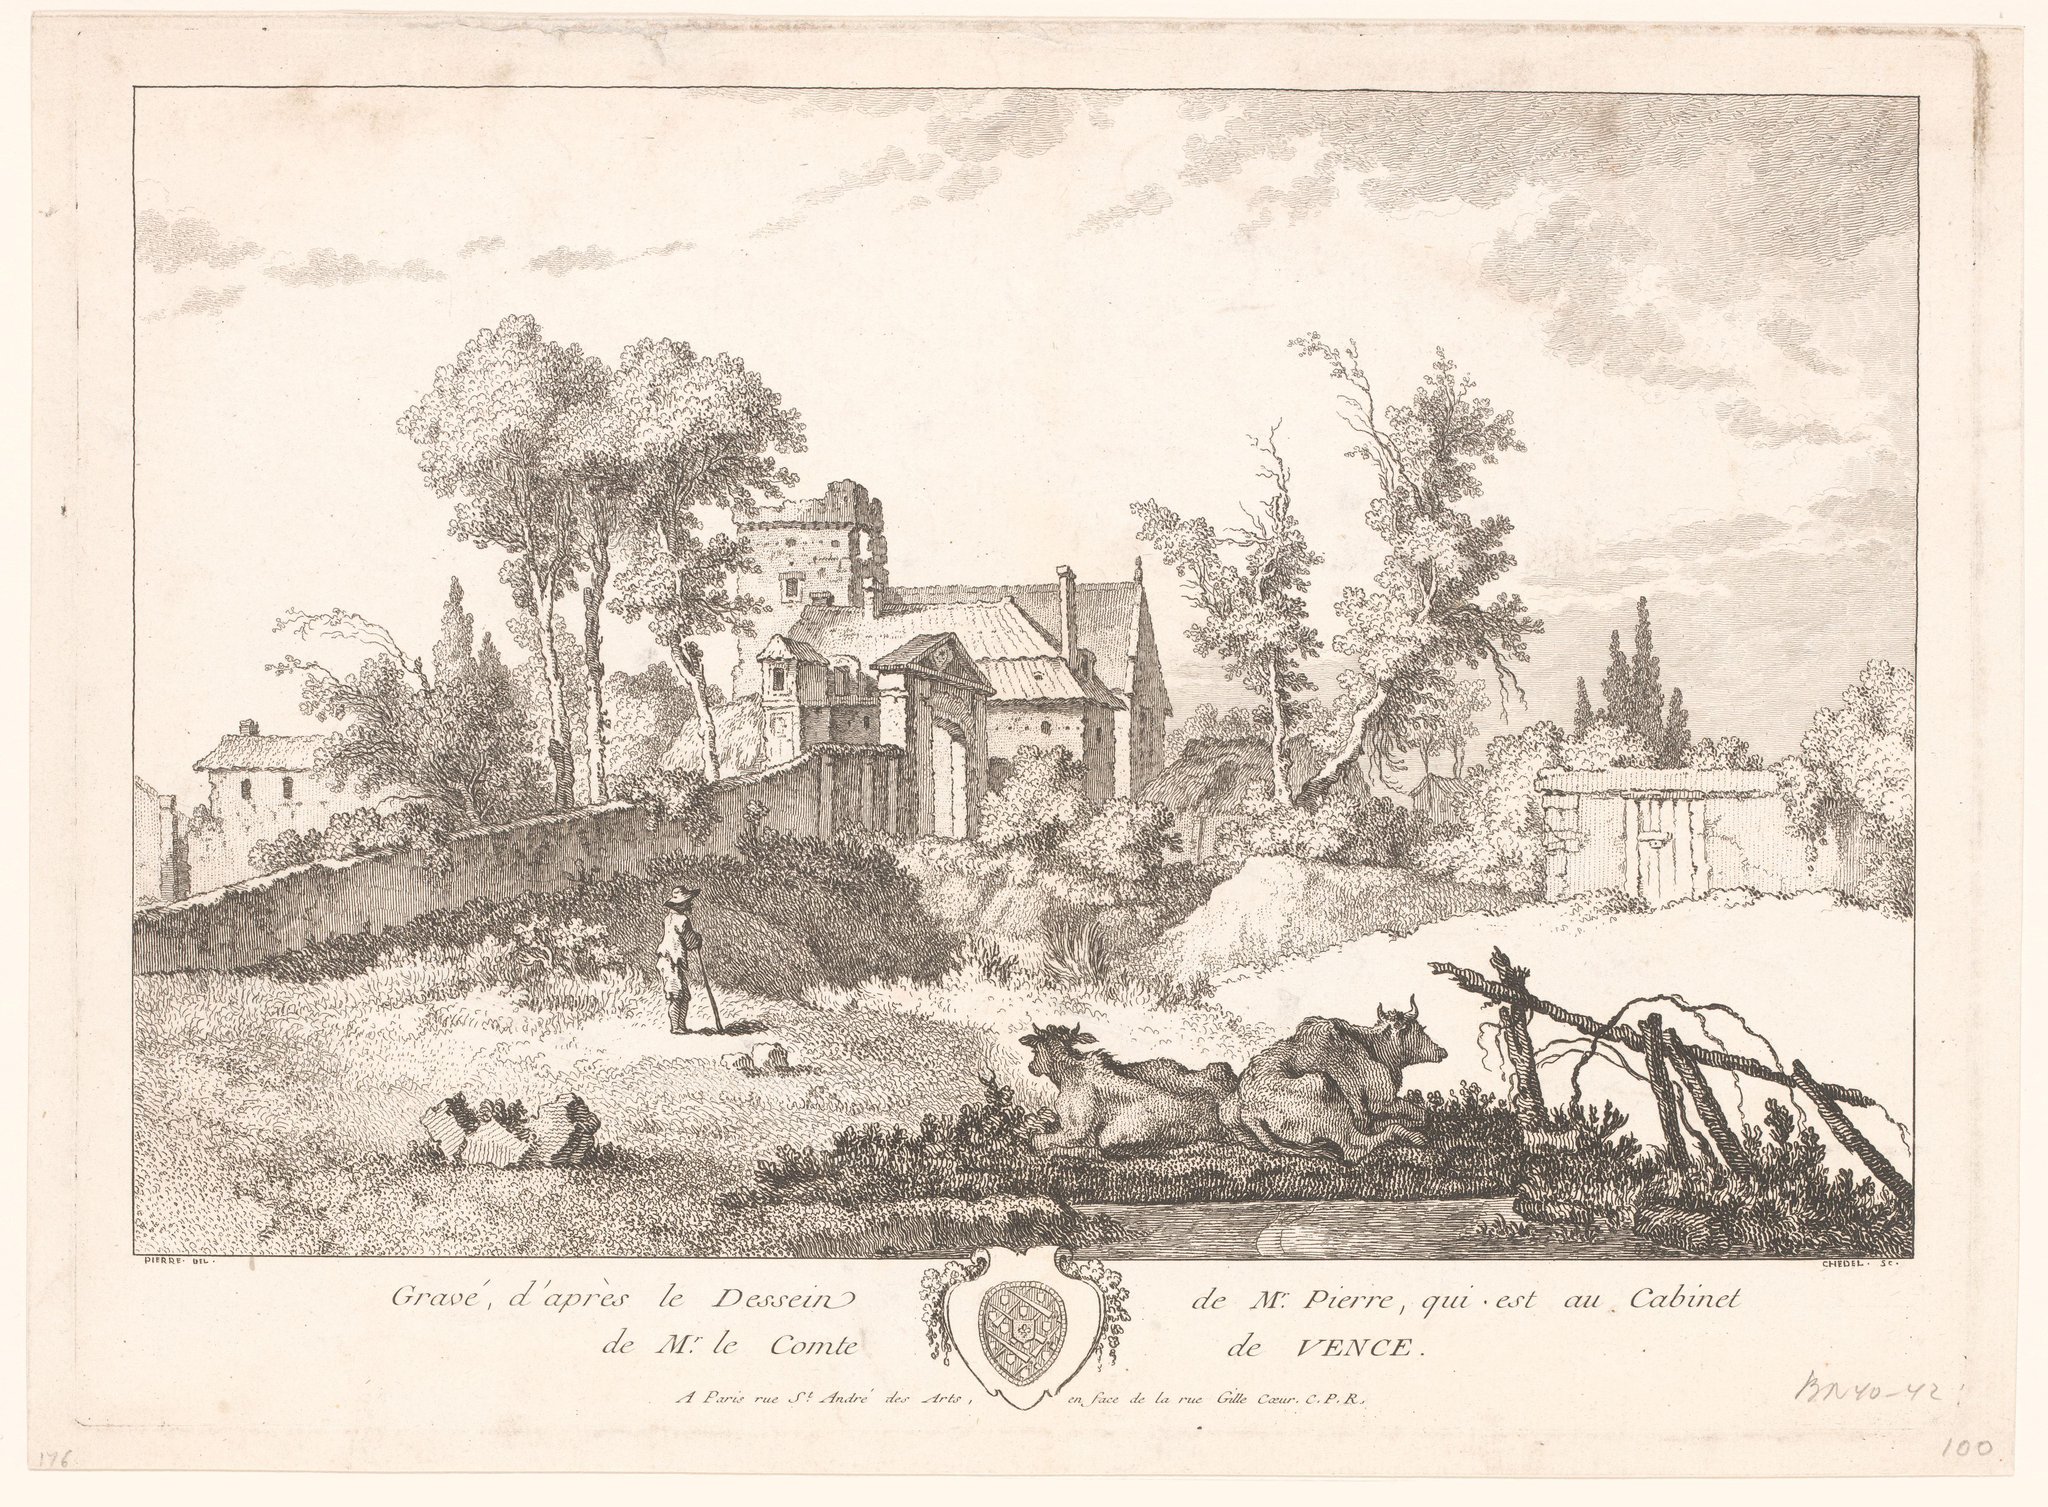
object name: print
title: Landschap aan de rand van een dorp, op de voorgrond twee koeien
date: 1715-1763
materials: paper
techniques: etching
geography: france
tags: city-view, and landscape with man-made constructions, cow, landscapes (+ landscape with figures, staffage)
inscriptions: collector's mark: Lugt 240